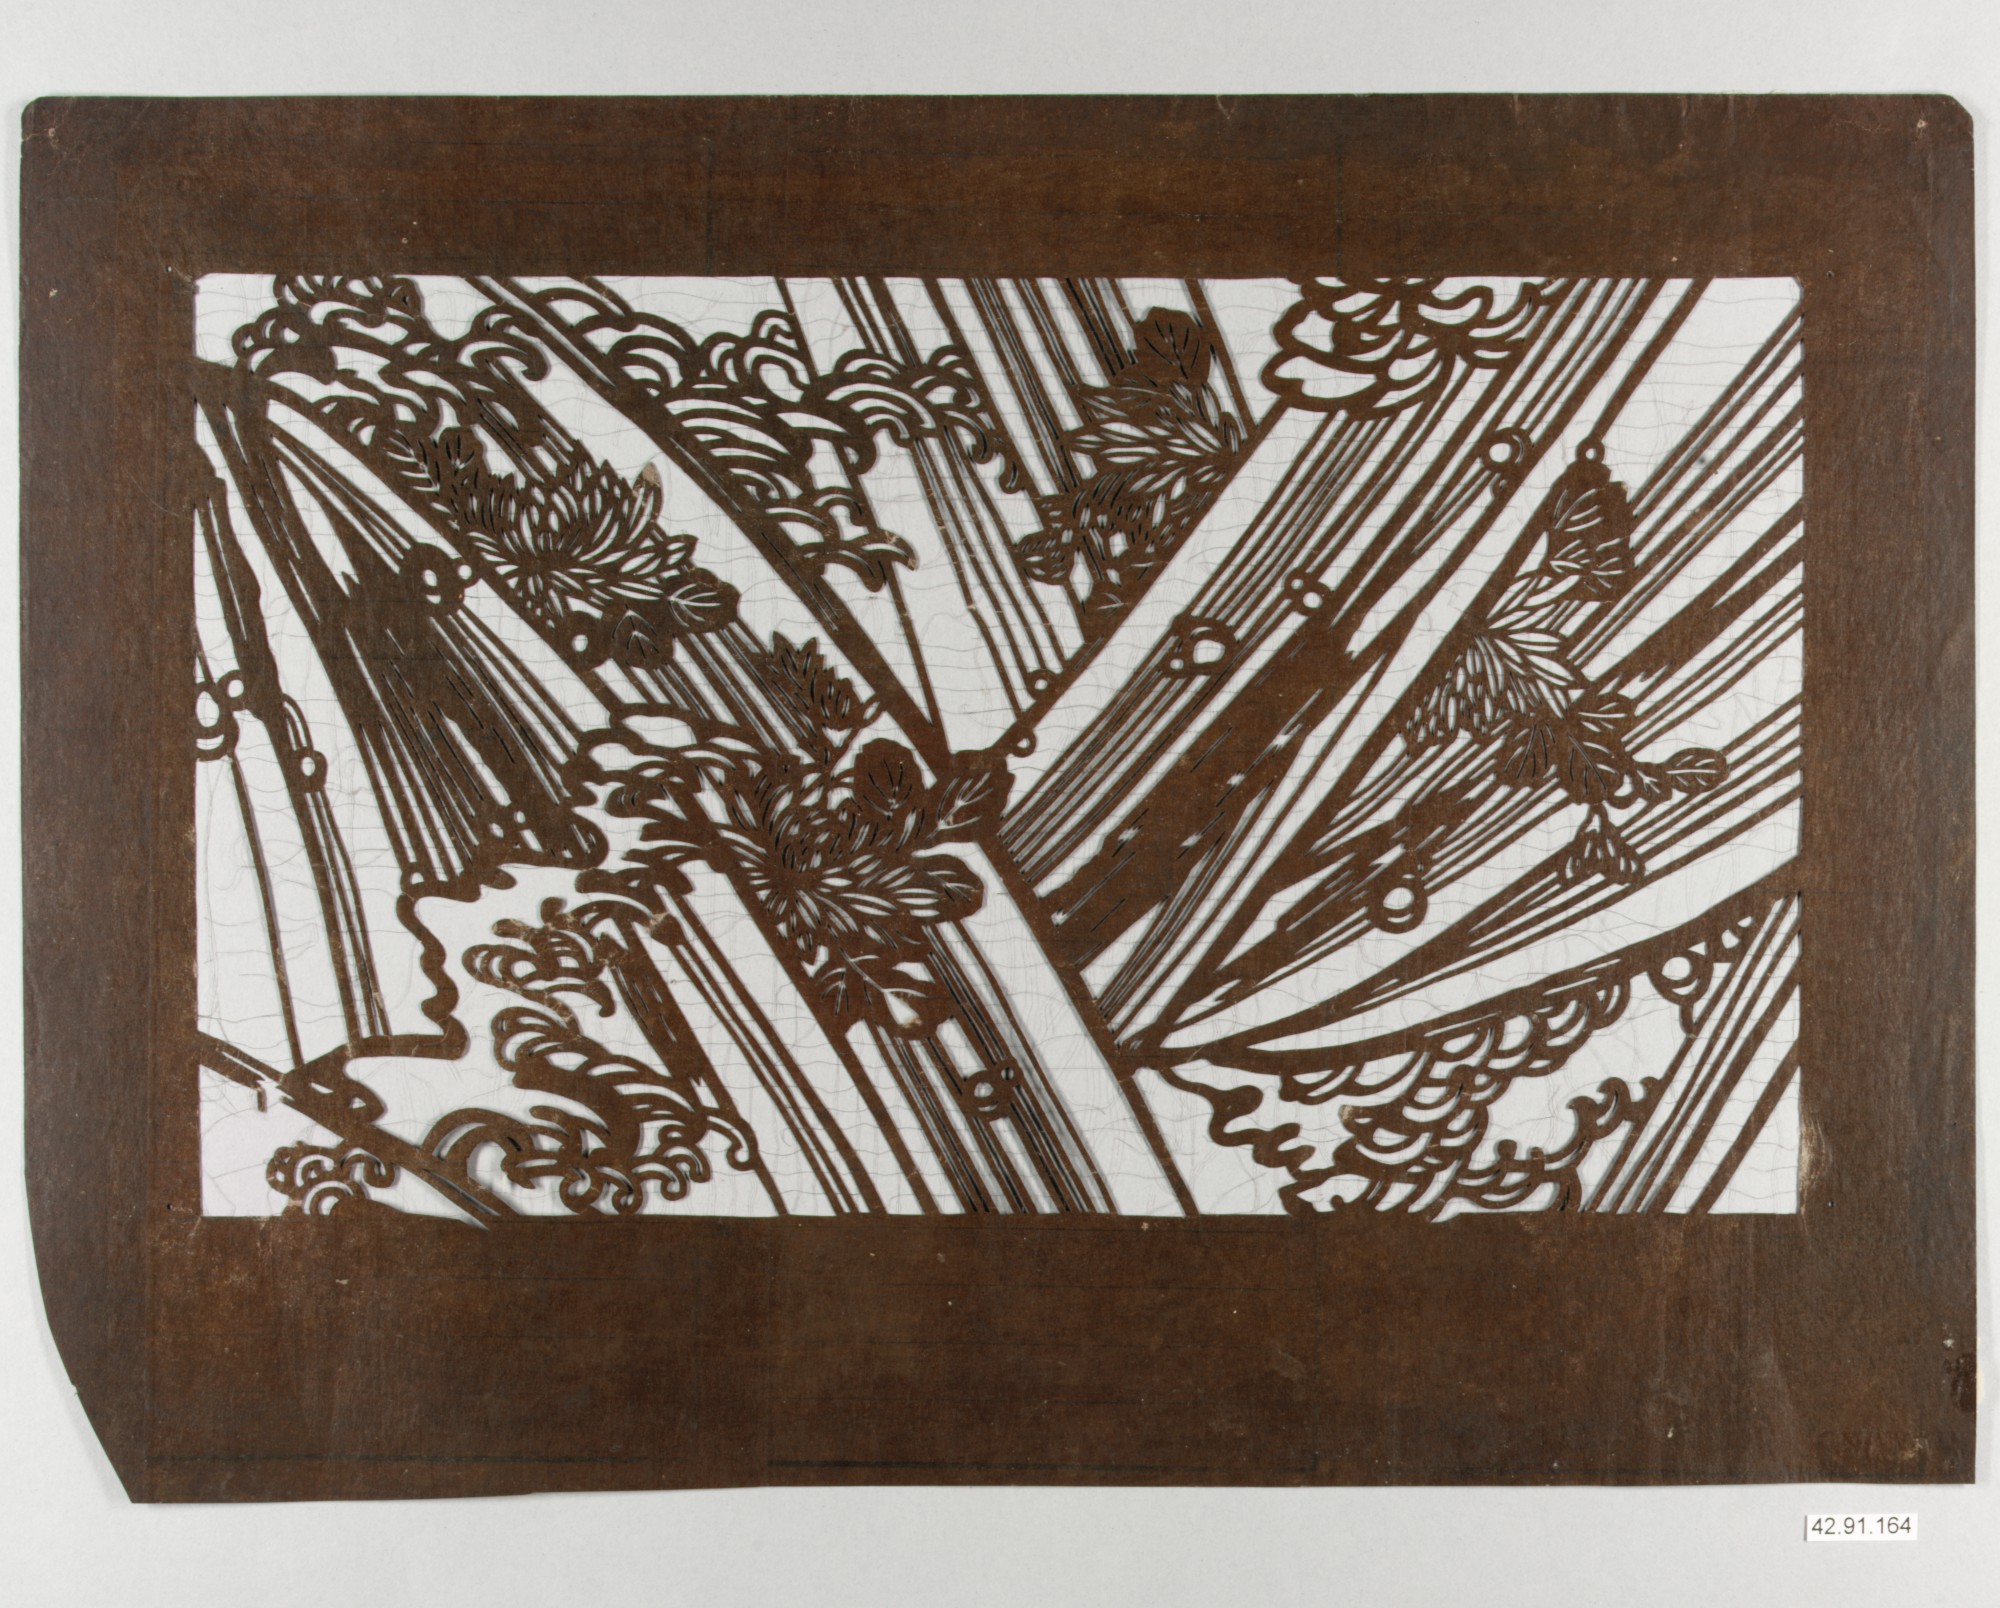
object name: stencil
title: Stencil with Pattern of Chrysanthemums in Rushing Water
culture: japanese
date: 1801-1900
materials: paper, silk